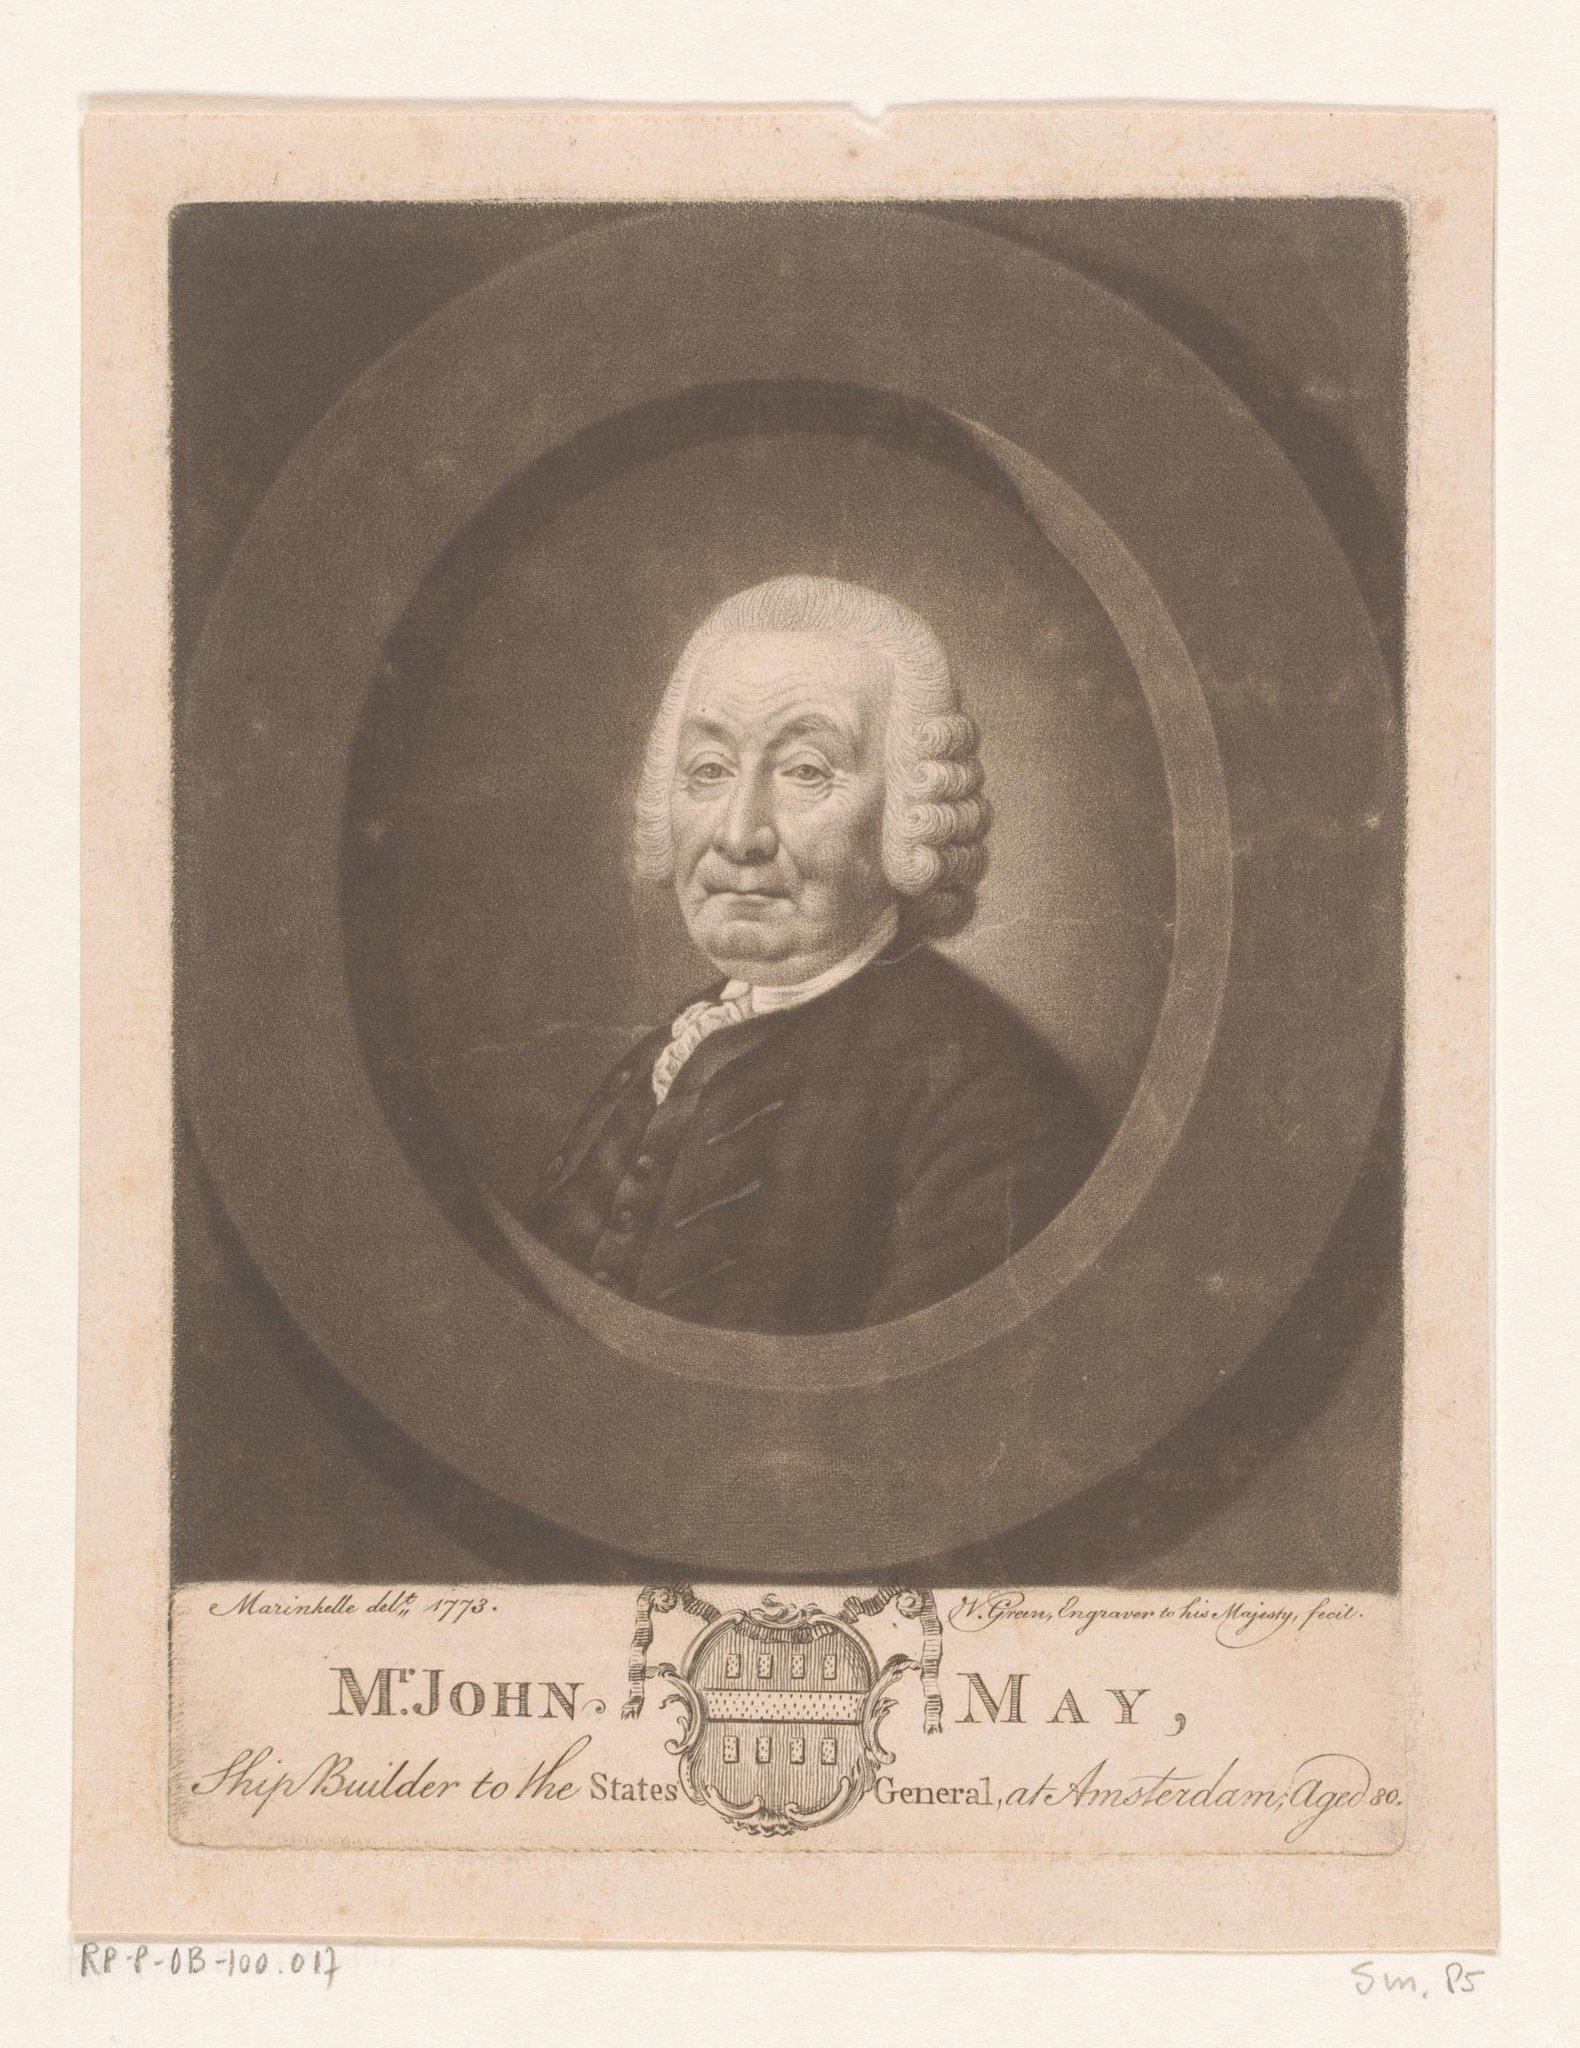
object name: print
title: Portret van John May op 80-jarige leeftijd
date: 1773-1813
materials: paper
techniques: etching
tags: historical persons, shipbuilding industry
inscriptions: collector's mark: Lugt 2228